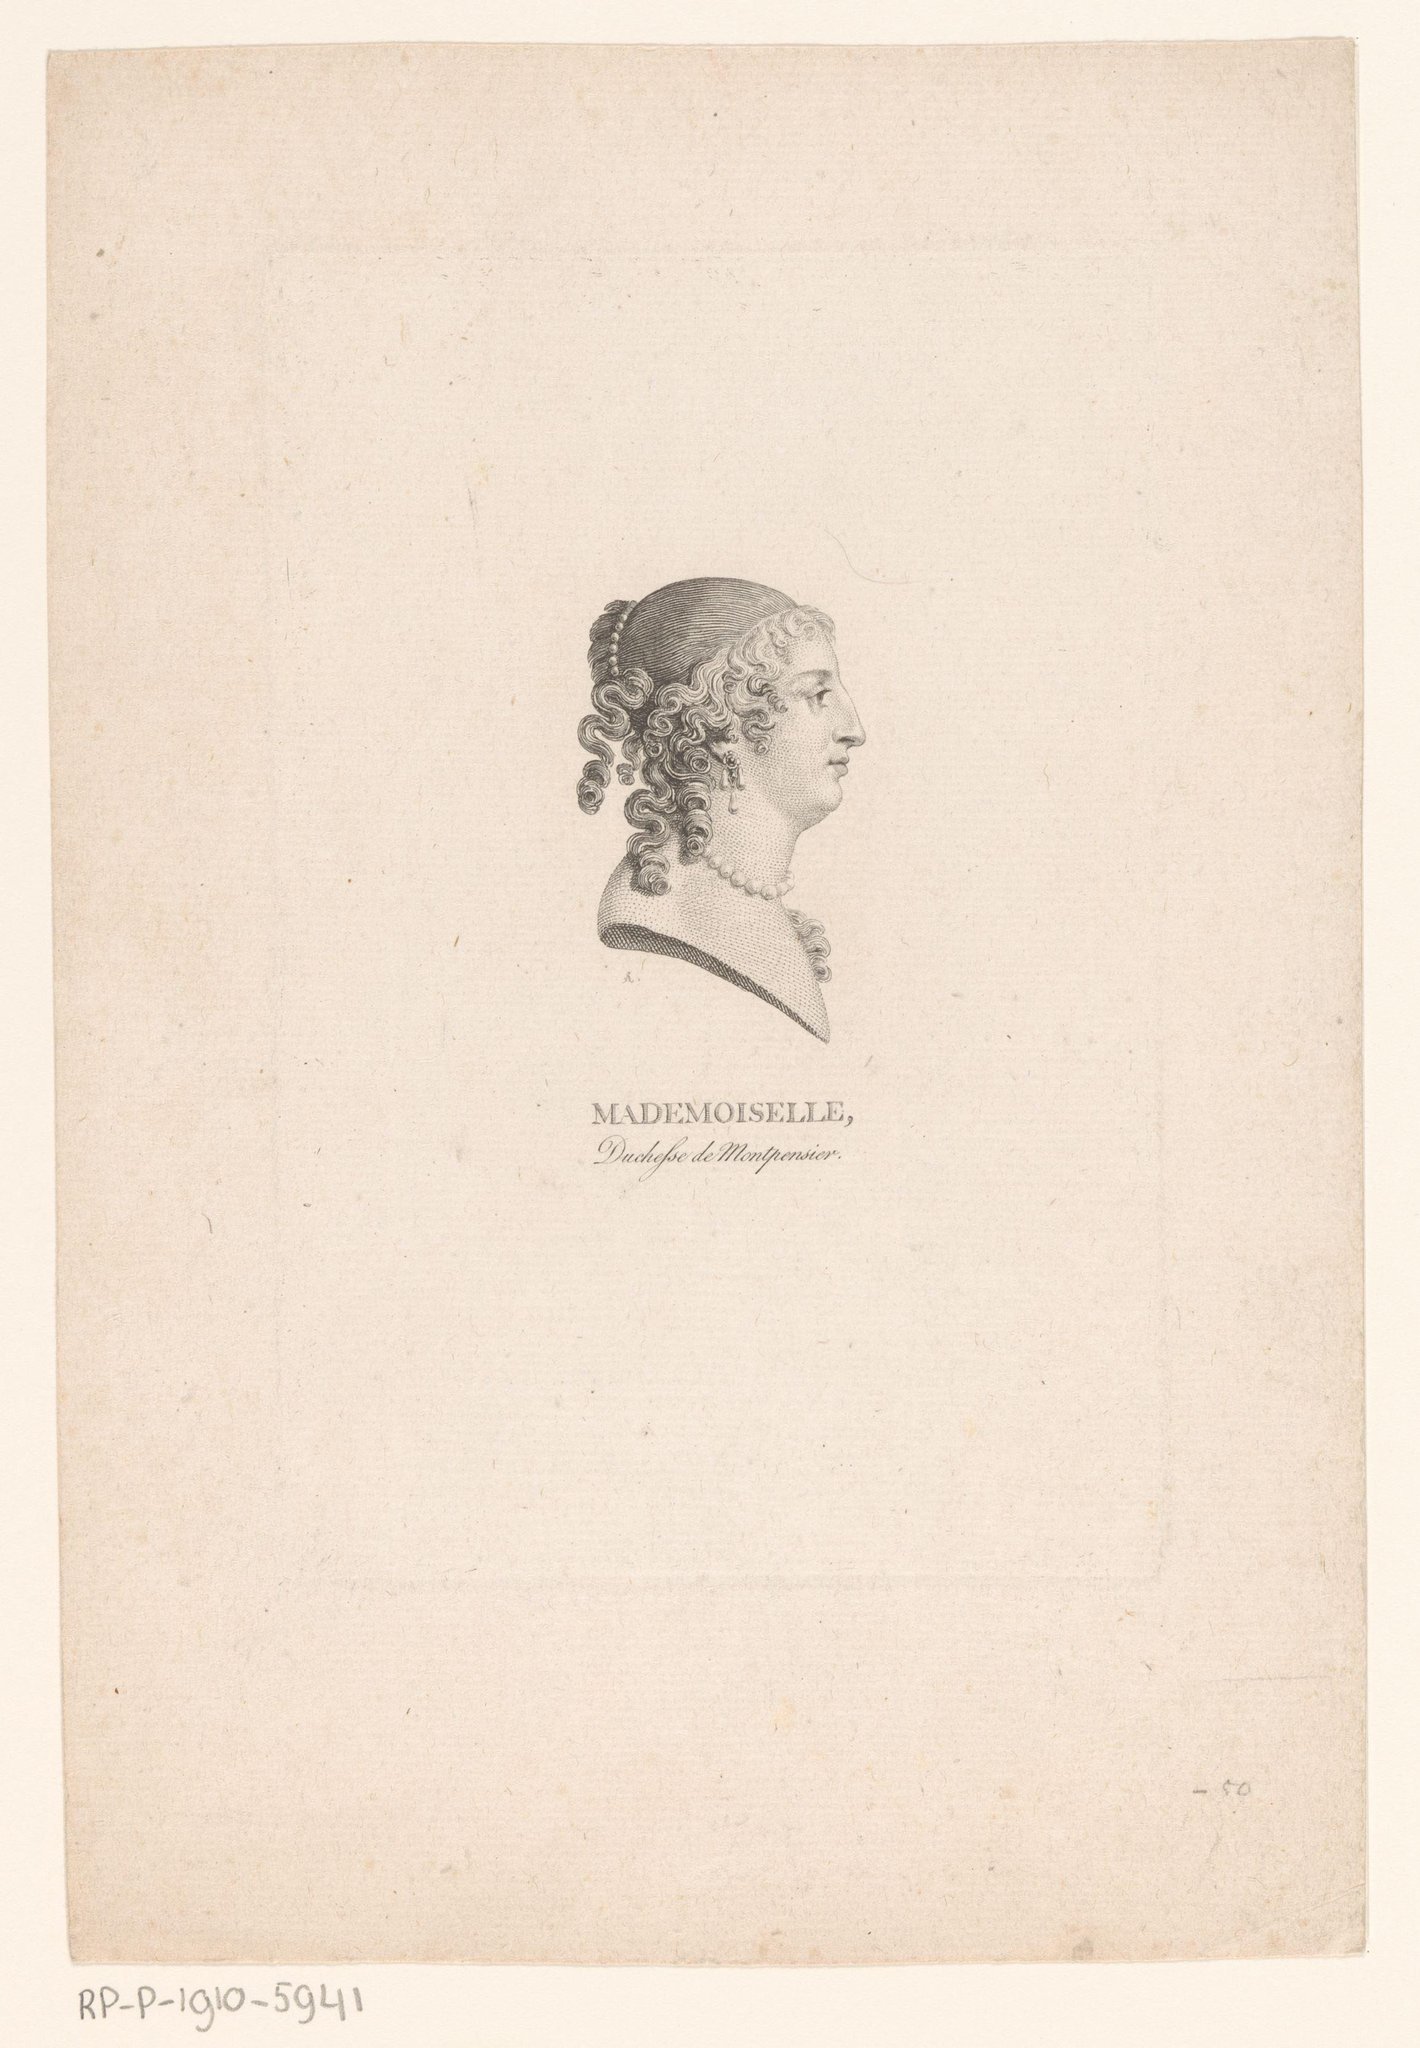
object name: print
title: Portret van Louise Elisabeth d'Orléans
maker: augustin de saint-aubin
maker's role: draughtsman, print maker, publisher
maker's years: 1736-1807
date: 1746-1807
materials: paper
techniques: engraving, etching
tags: historical persons, queen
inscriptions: collector's mark: Lugt 2228